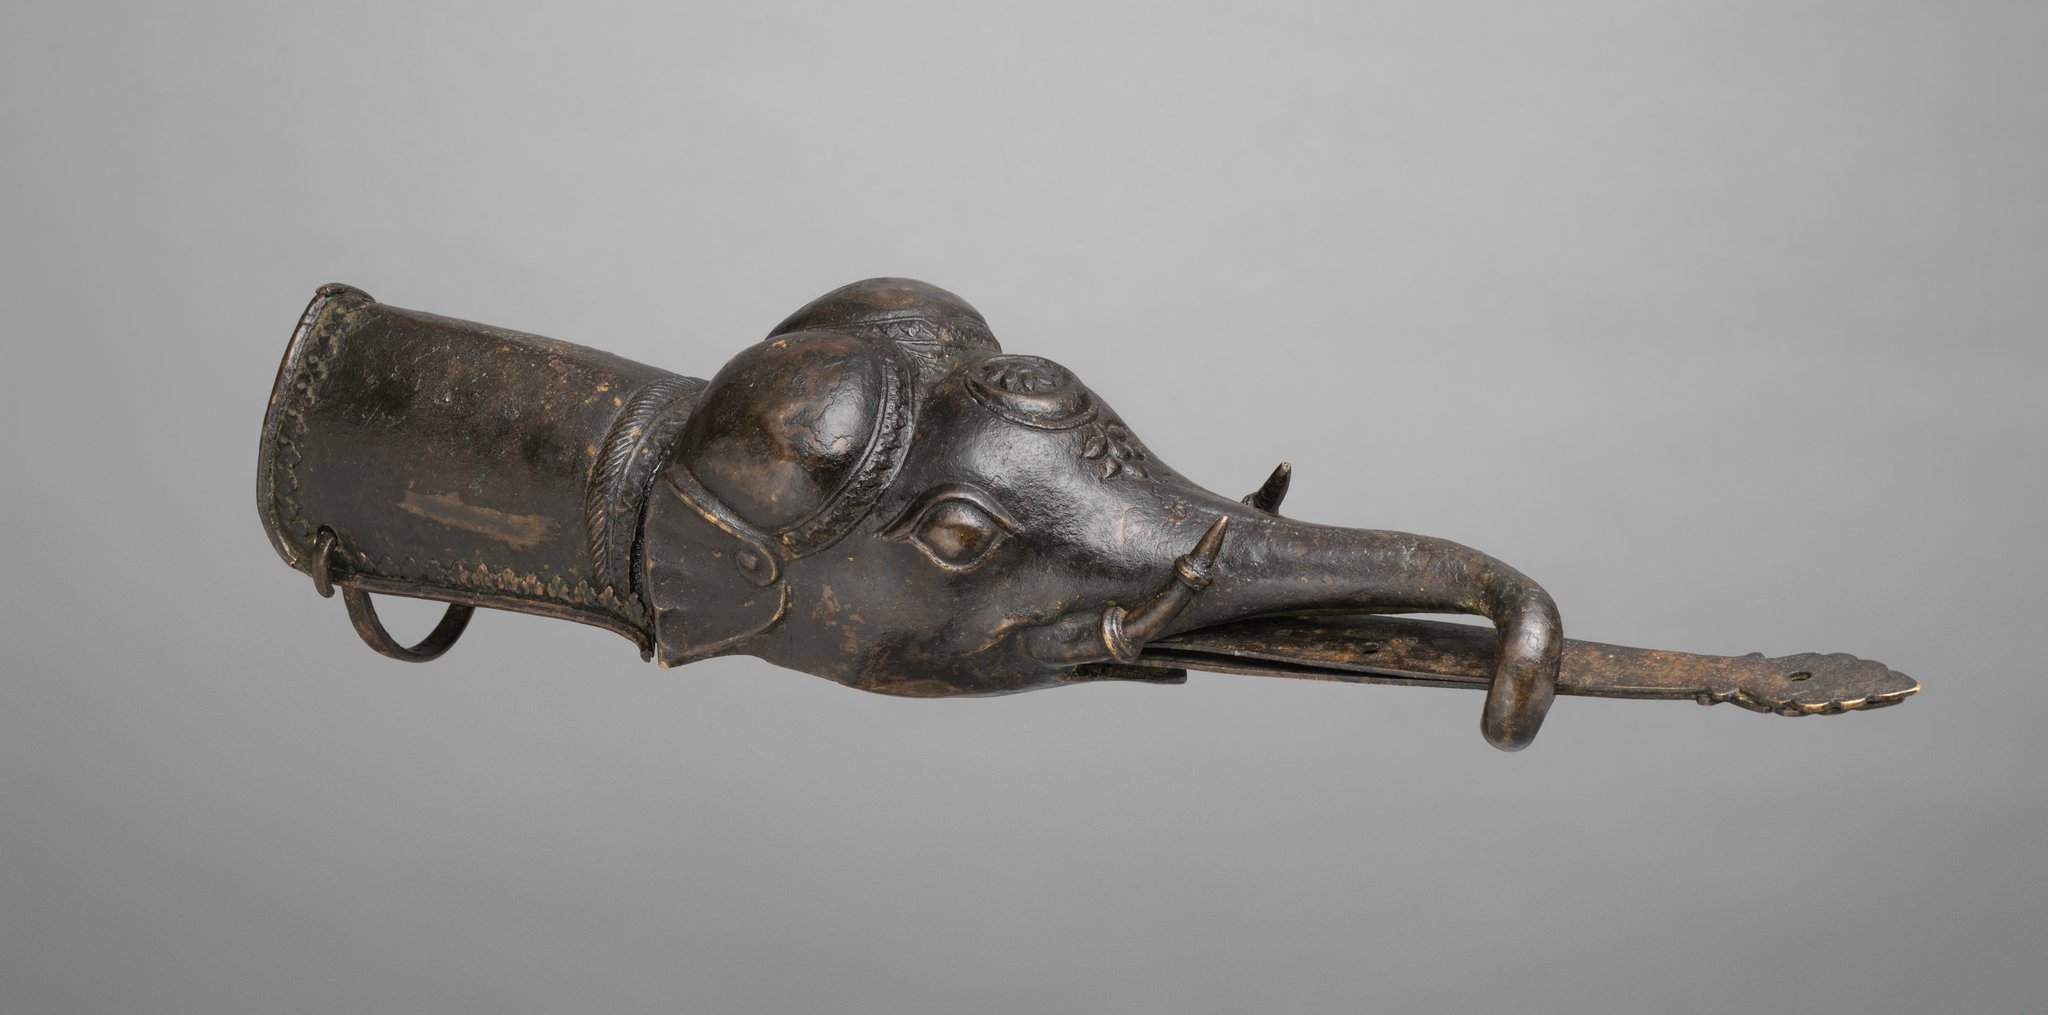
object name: hilt of a gauntlet sword i pata i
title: Hilt of a Gauntlet Sword (Pata)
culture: indian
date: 1601-1800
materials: copper alloy, iron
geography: india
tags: elephants